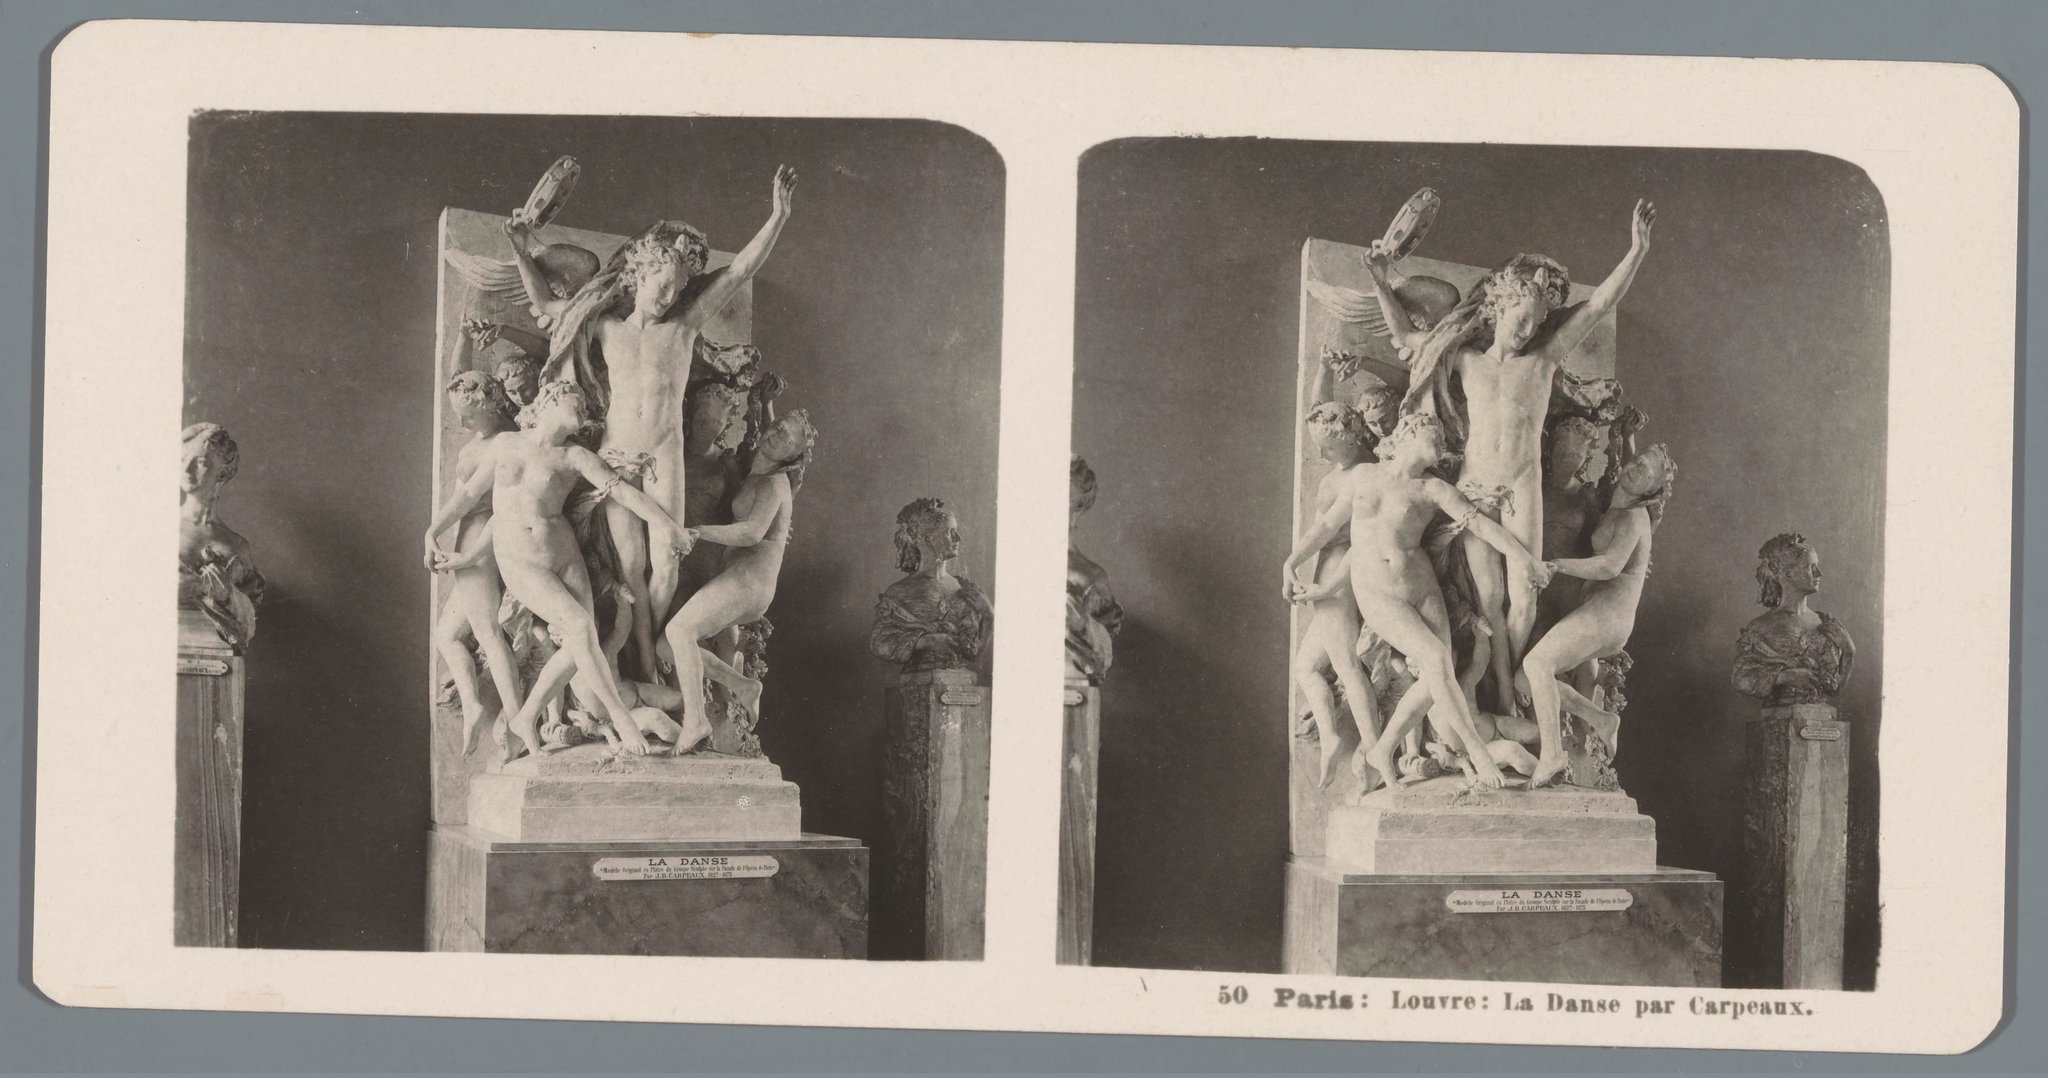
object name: stereograph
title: Gipsmodel van de sculptuur La danse van Jean-Baptiste Carpeaux in het Musée du Louvre te Parijs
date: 1904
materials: cardboard, photographic support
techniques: gelatin silver print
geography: louvre museum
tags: sculpture, amalthea, the nymph, usually in the shape of a goat, suckles the new-born jupiter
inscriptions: number: ‘50’, inscription: ‘Neue Photographische Gesellschaft A.-G. Steglitz-Berlin 1904.’